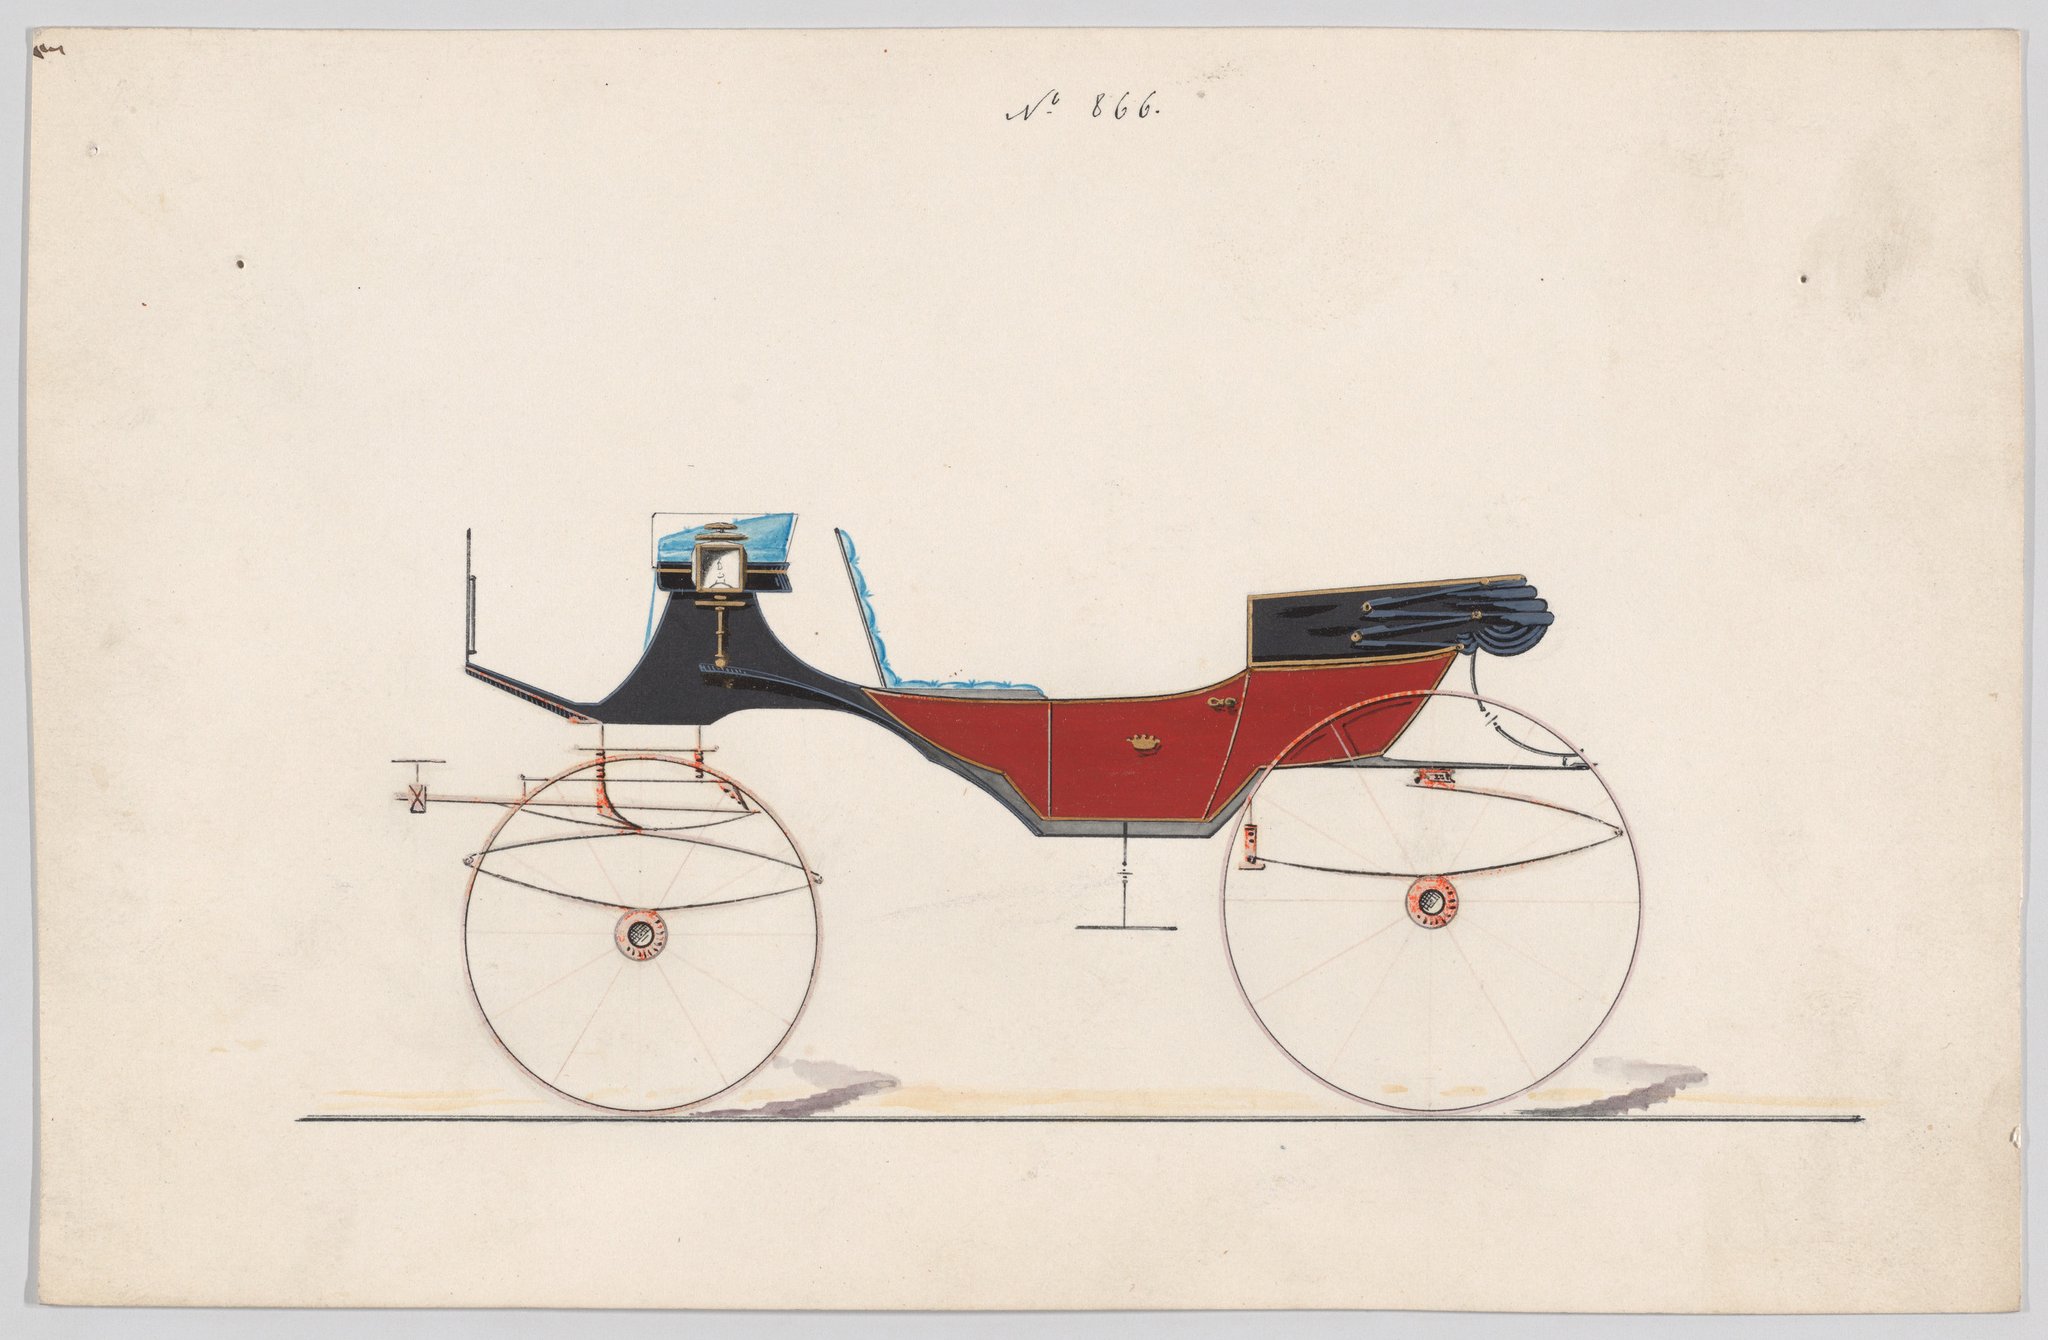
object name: drawing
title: Design for Vis-à-vis, no. 866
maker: brewster & co.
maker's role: manufacturer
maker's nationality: american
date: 1850-1870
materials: gouache, gum arabic, ink, watercolor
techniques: pen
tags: carriages